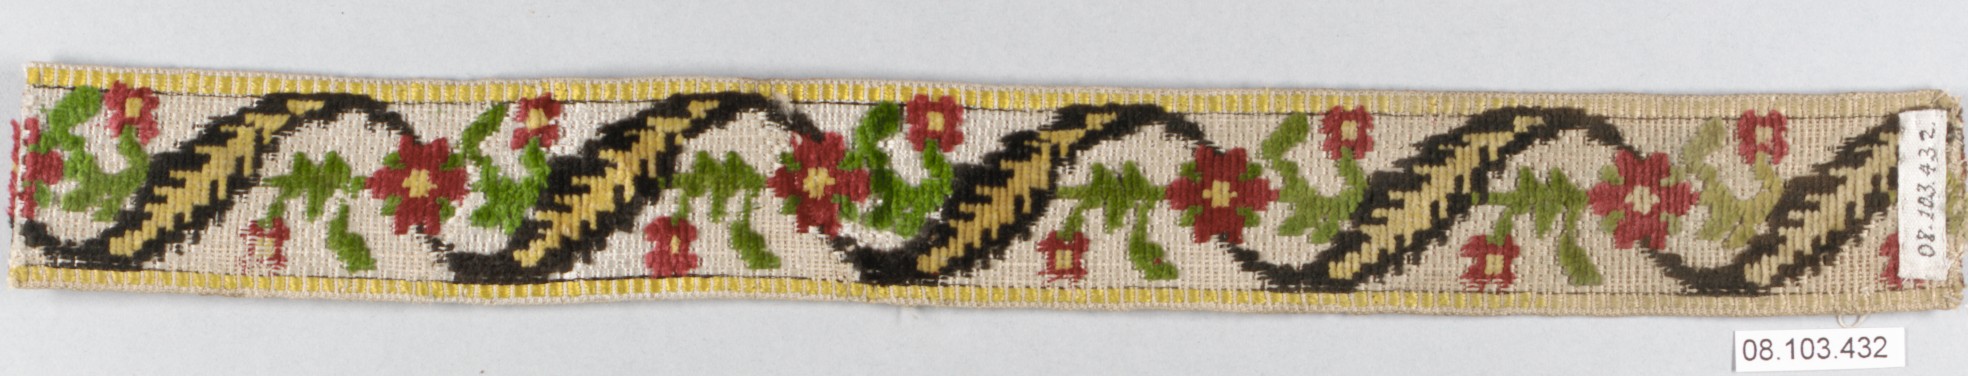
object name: galloon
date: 1701-1900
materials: silk